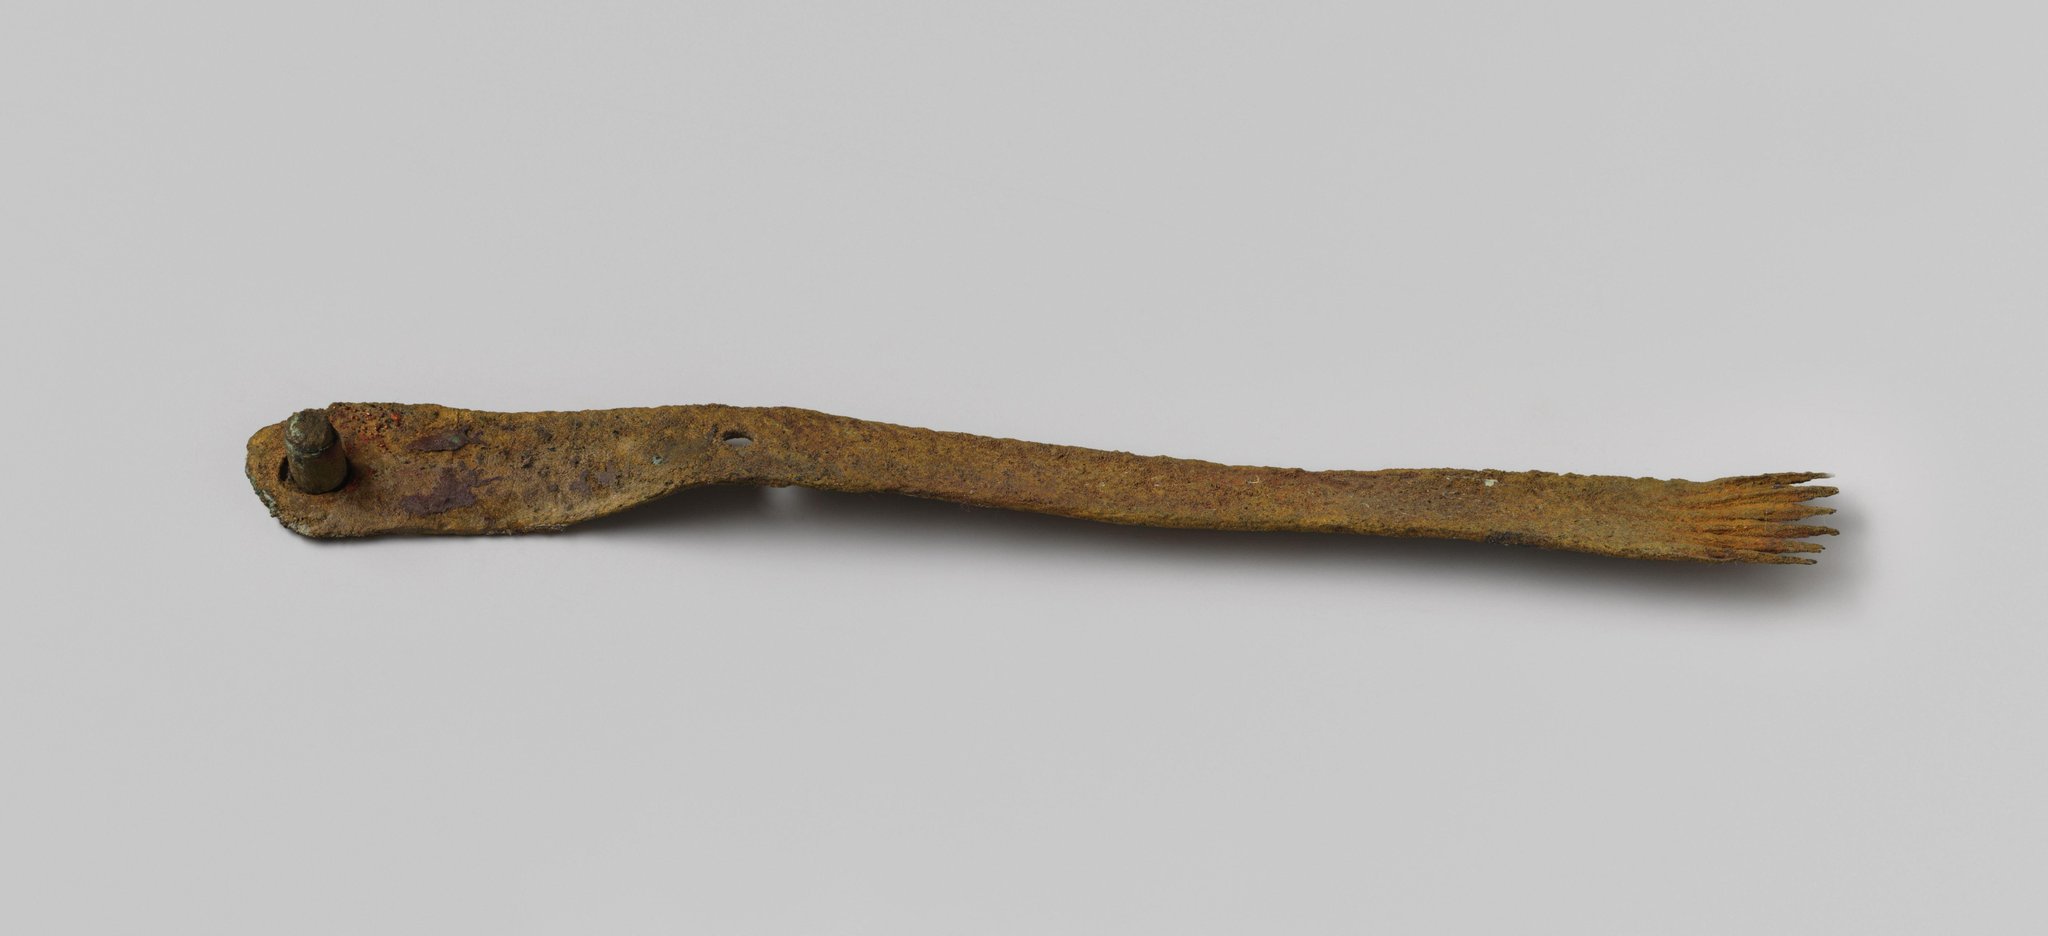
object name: fragment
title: Fragment van koper uit het wrak van de Oost-Indiëvaarder Hollandia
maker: Anonymous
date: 1700-1743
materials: copper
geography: netherlands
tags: verenigde oostindische compagnie, hollandia (schip), annet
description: Varied parts or fragments, unidentified and miscellaneous parts or fragments; fragm.